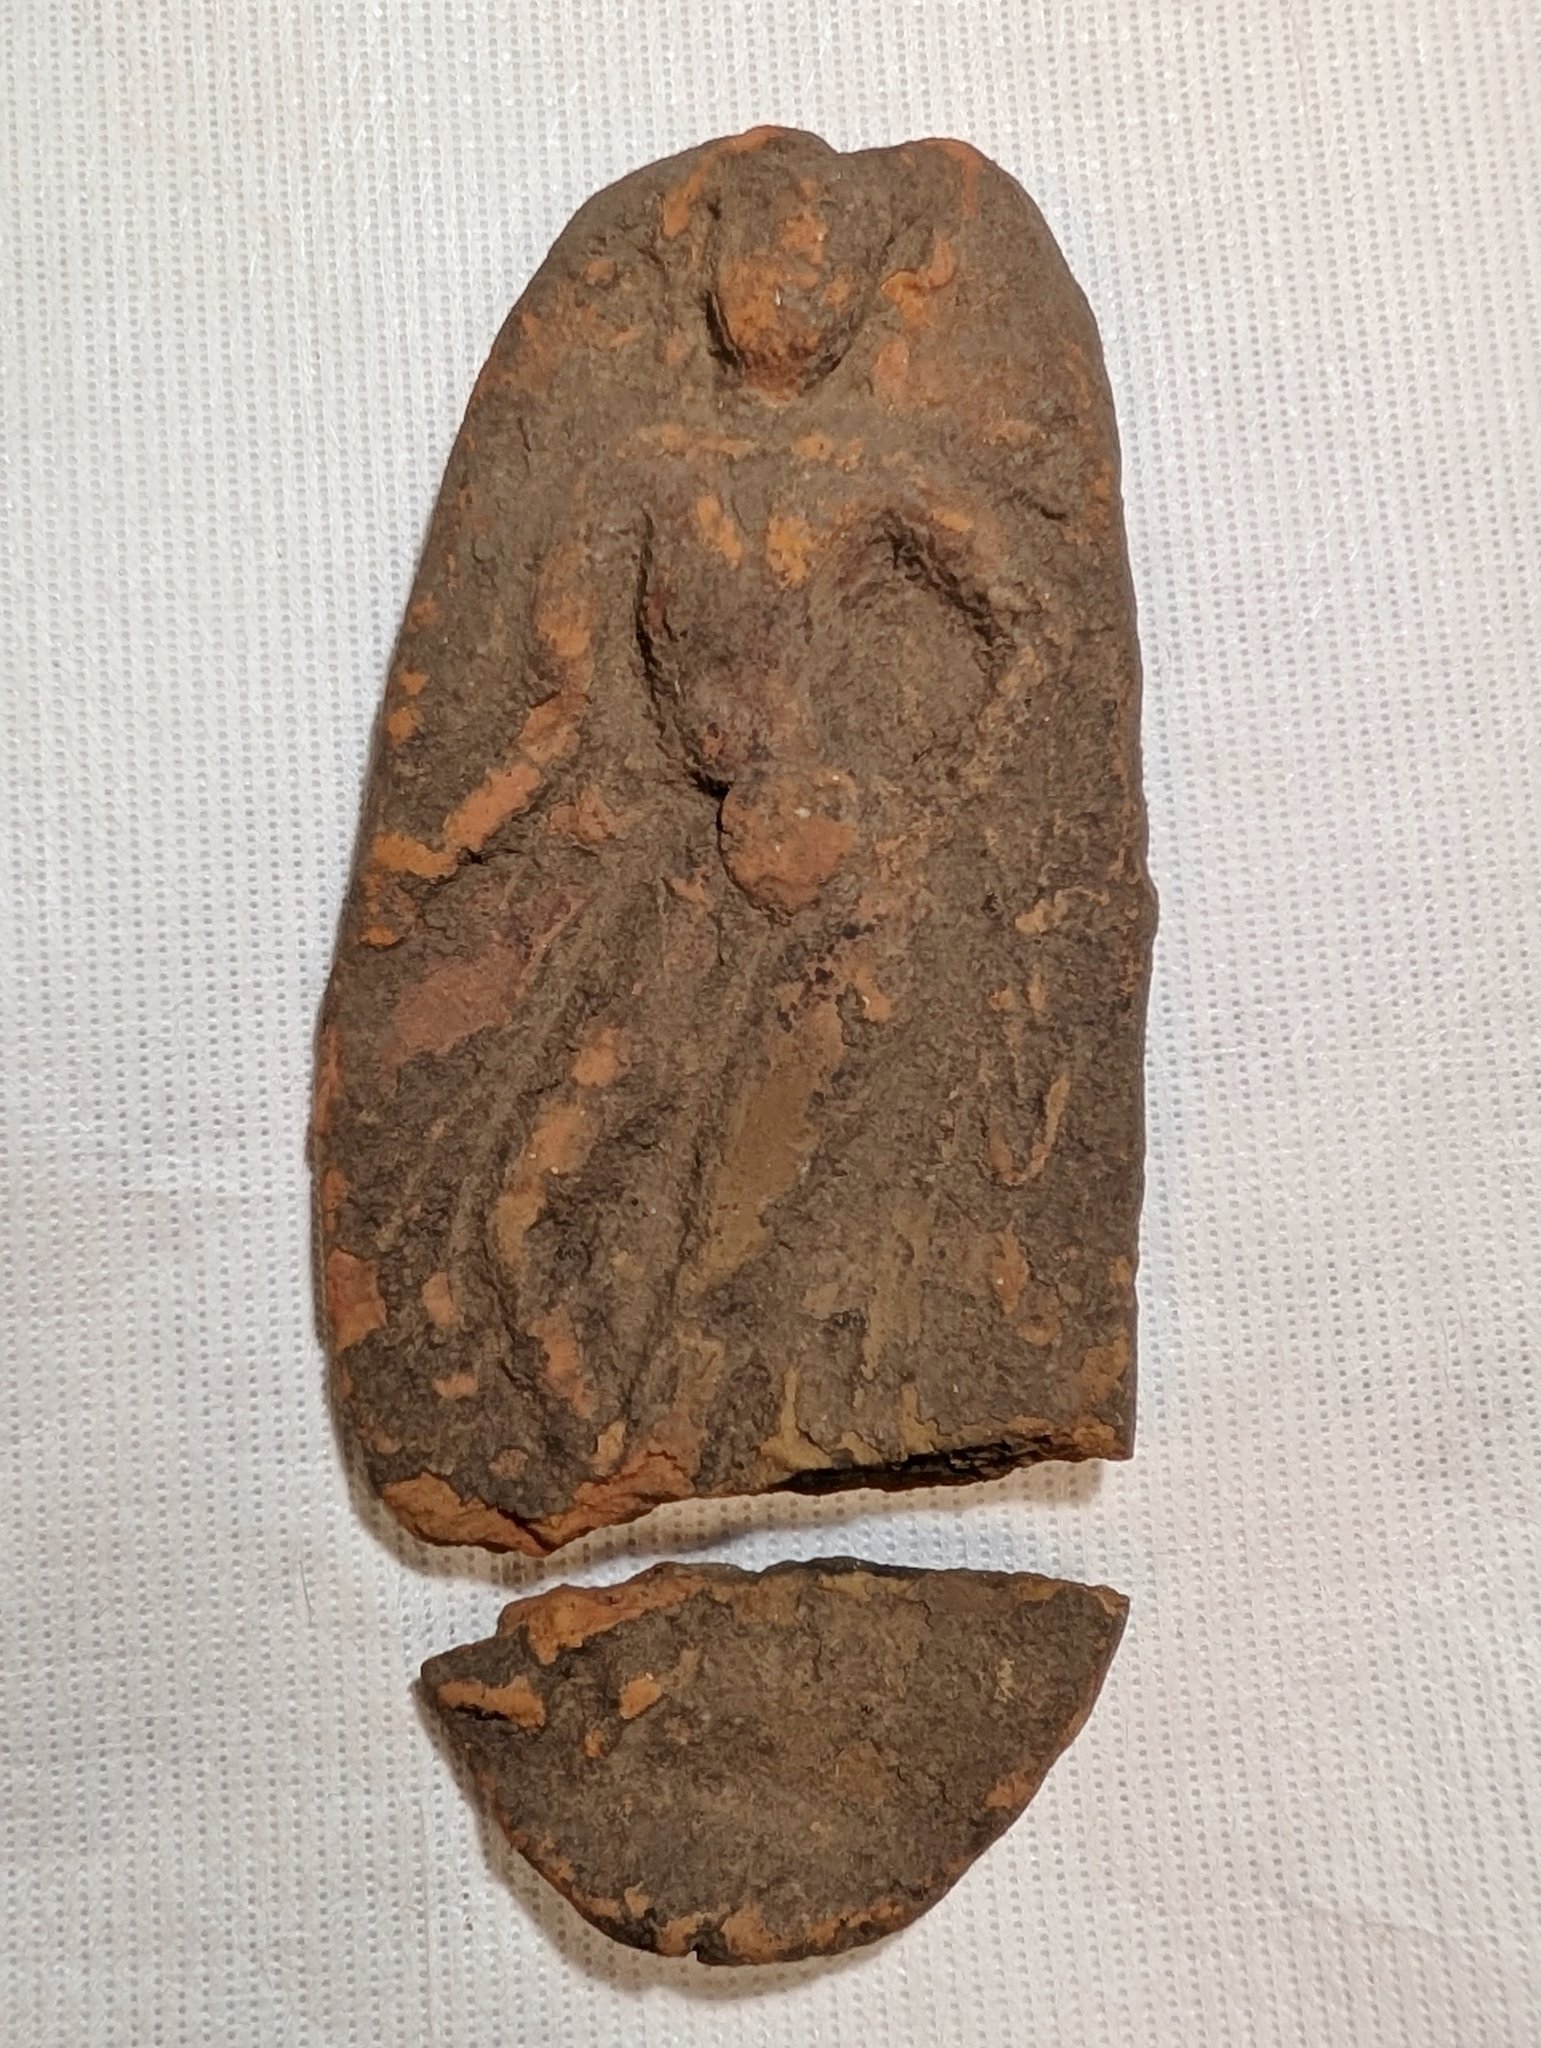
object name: plaque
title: Plaque in the Form of a Female Figure (Study Collection)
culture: pakistani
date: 101-300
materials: terracotta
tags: gandhara